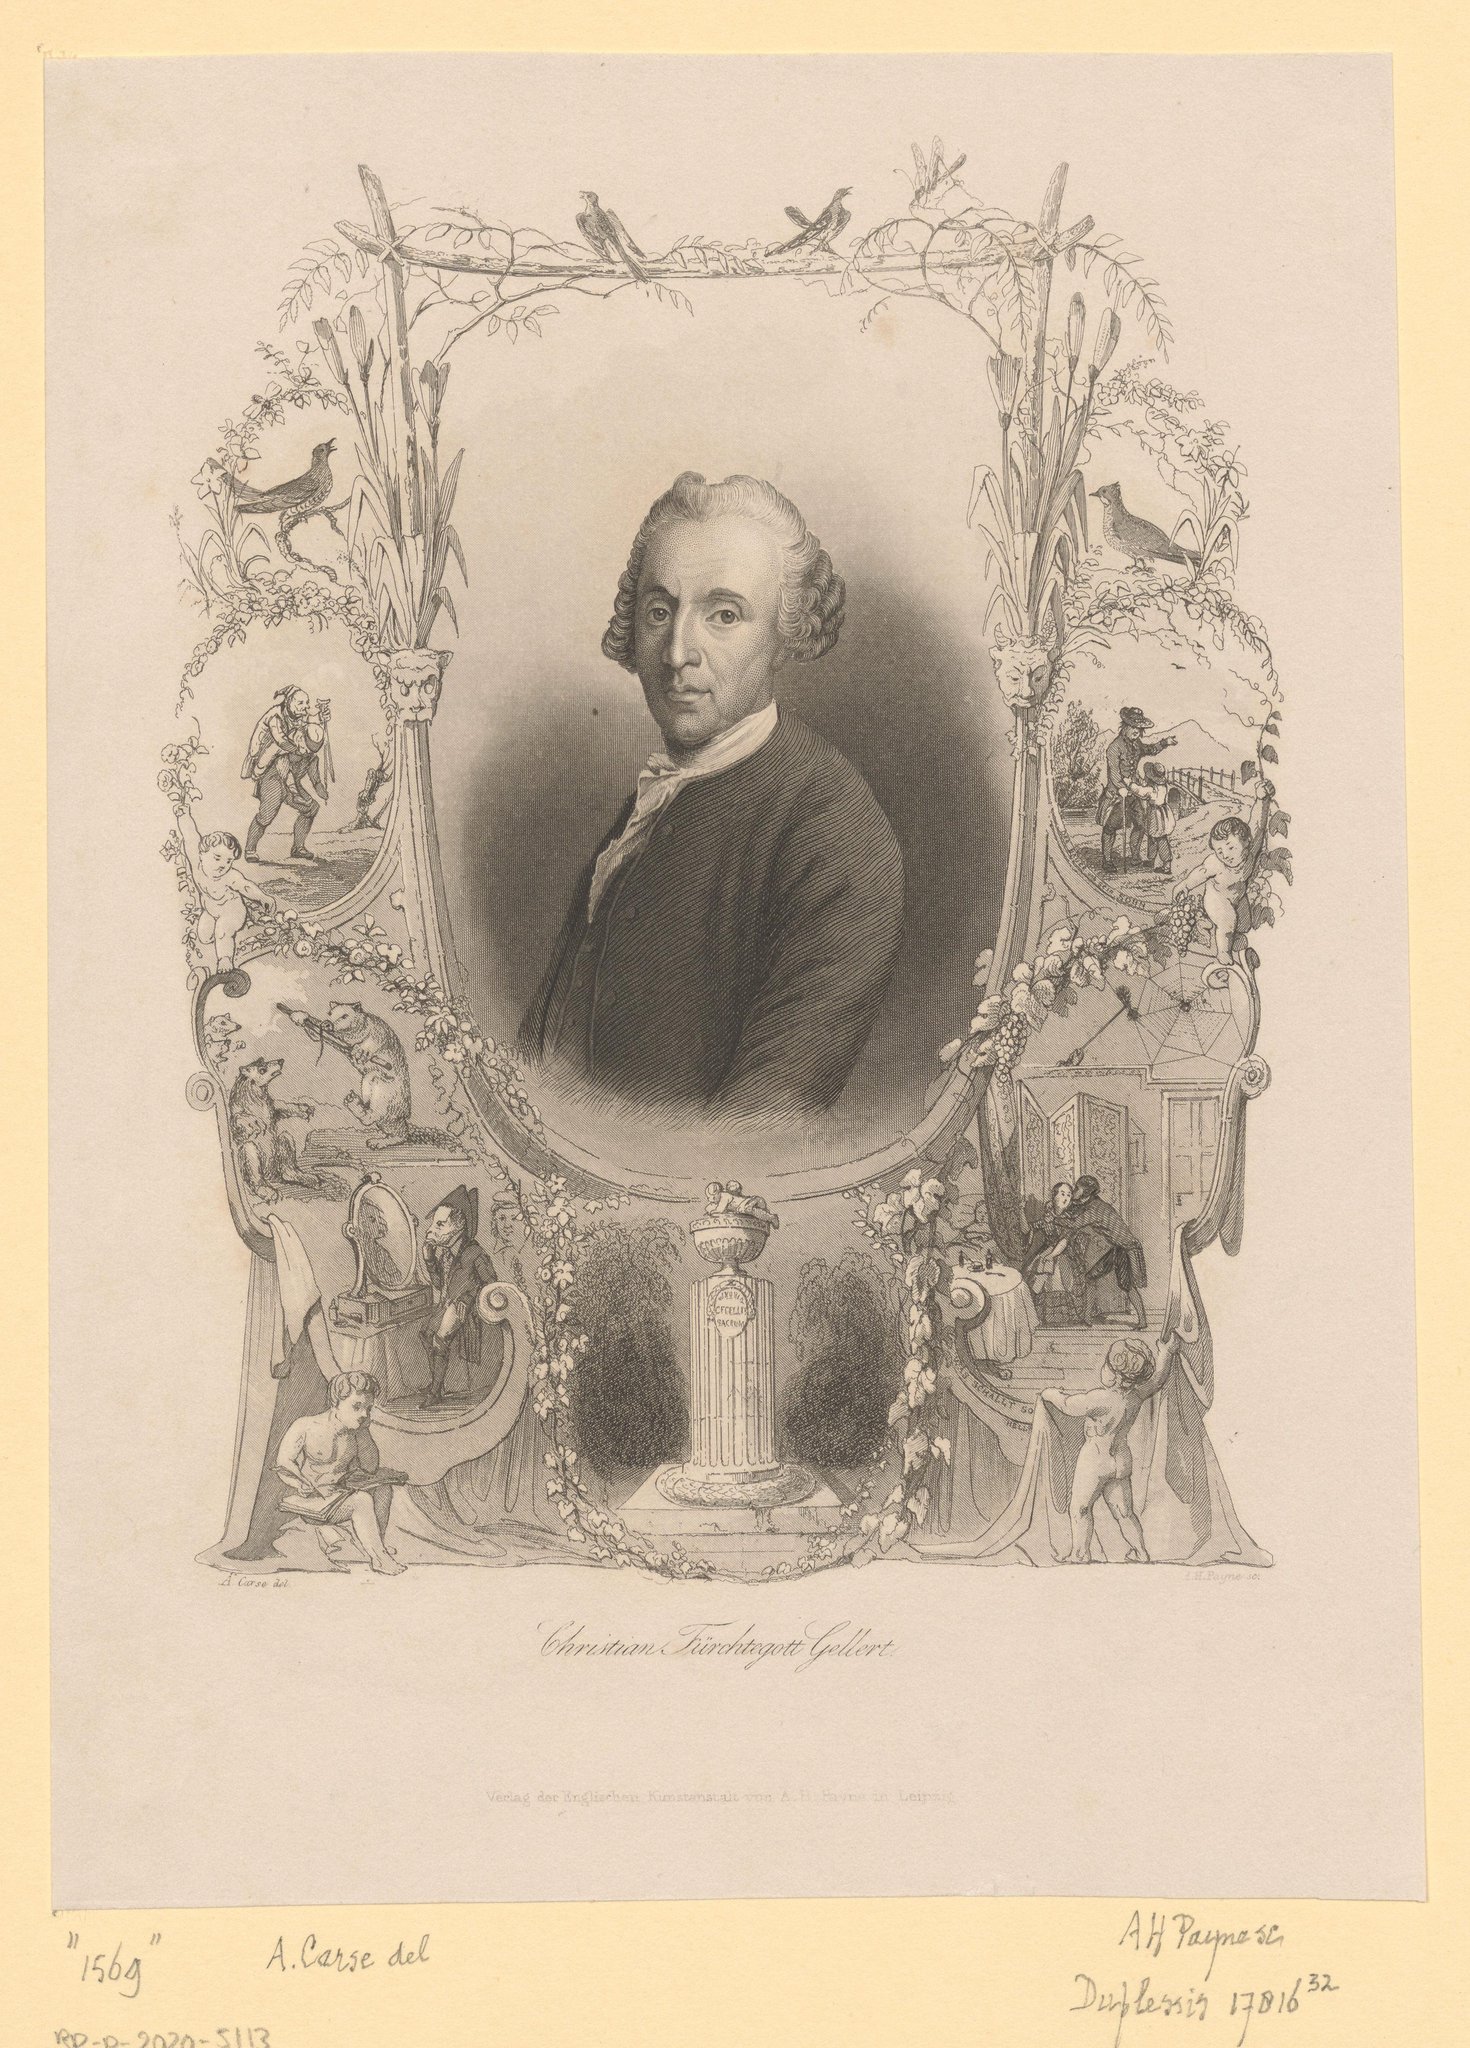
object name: print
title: Portret van Christian Furchtegott Gellert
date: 1838-1902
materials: paper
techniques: engraving, etching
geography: leipzig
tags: decoration of printed matter, historical persons, writer, poet, author